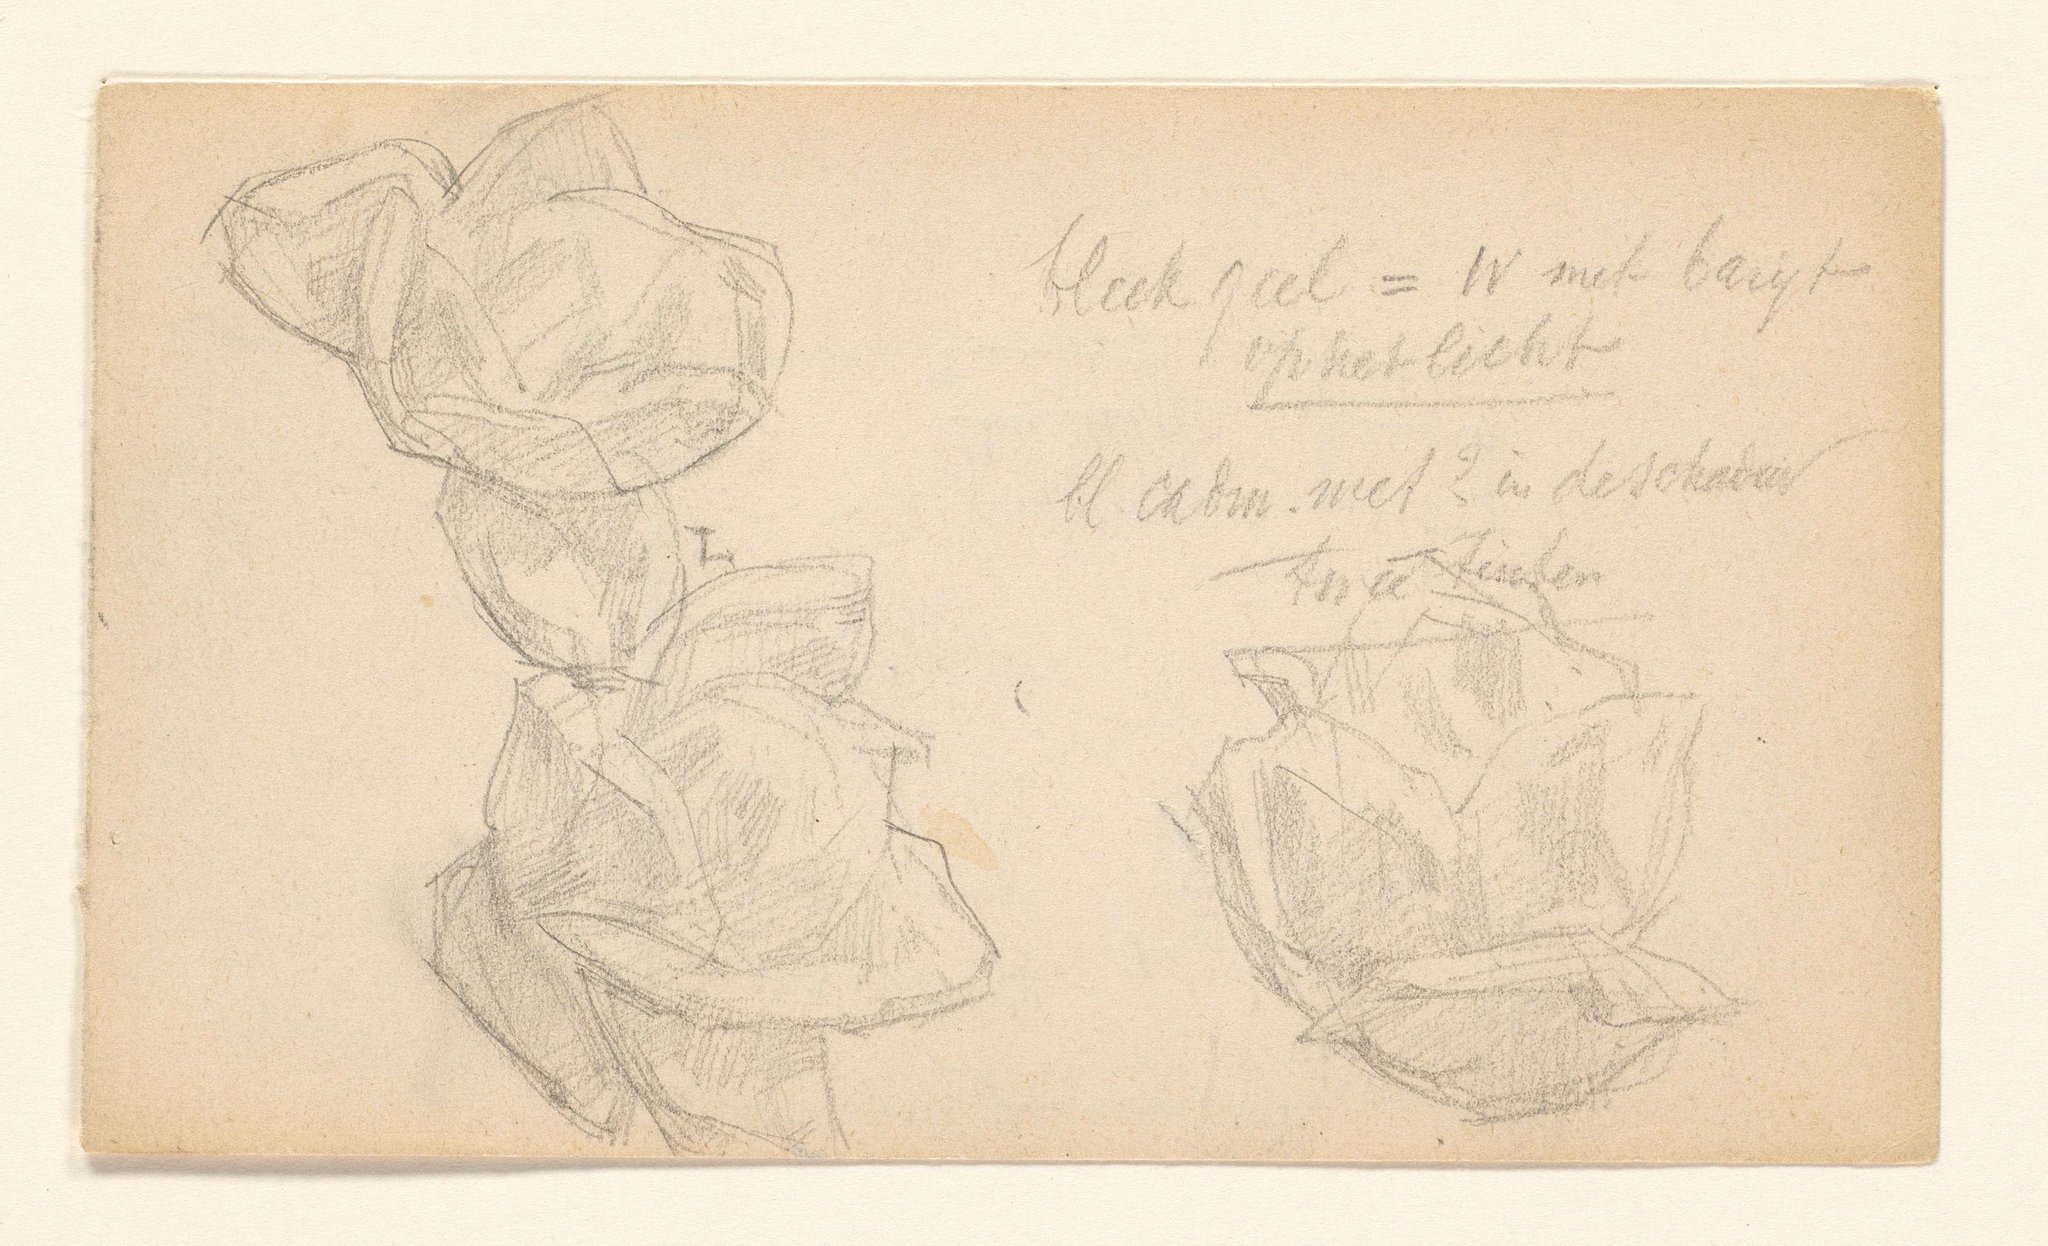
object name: drawing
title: Schetsblad met drie rozen (?)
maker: august allebé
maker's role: draughtsman, print maker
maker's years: 1838-1927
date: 1848-1927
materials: paper, pencil